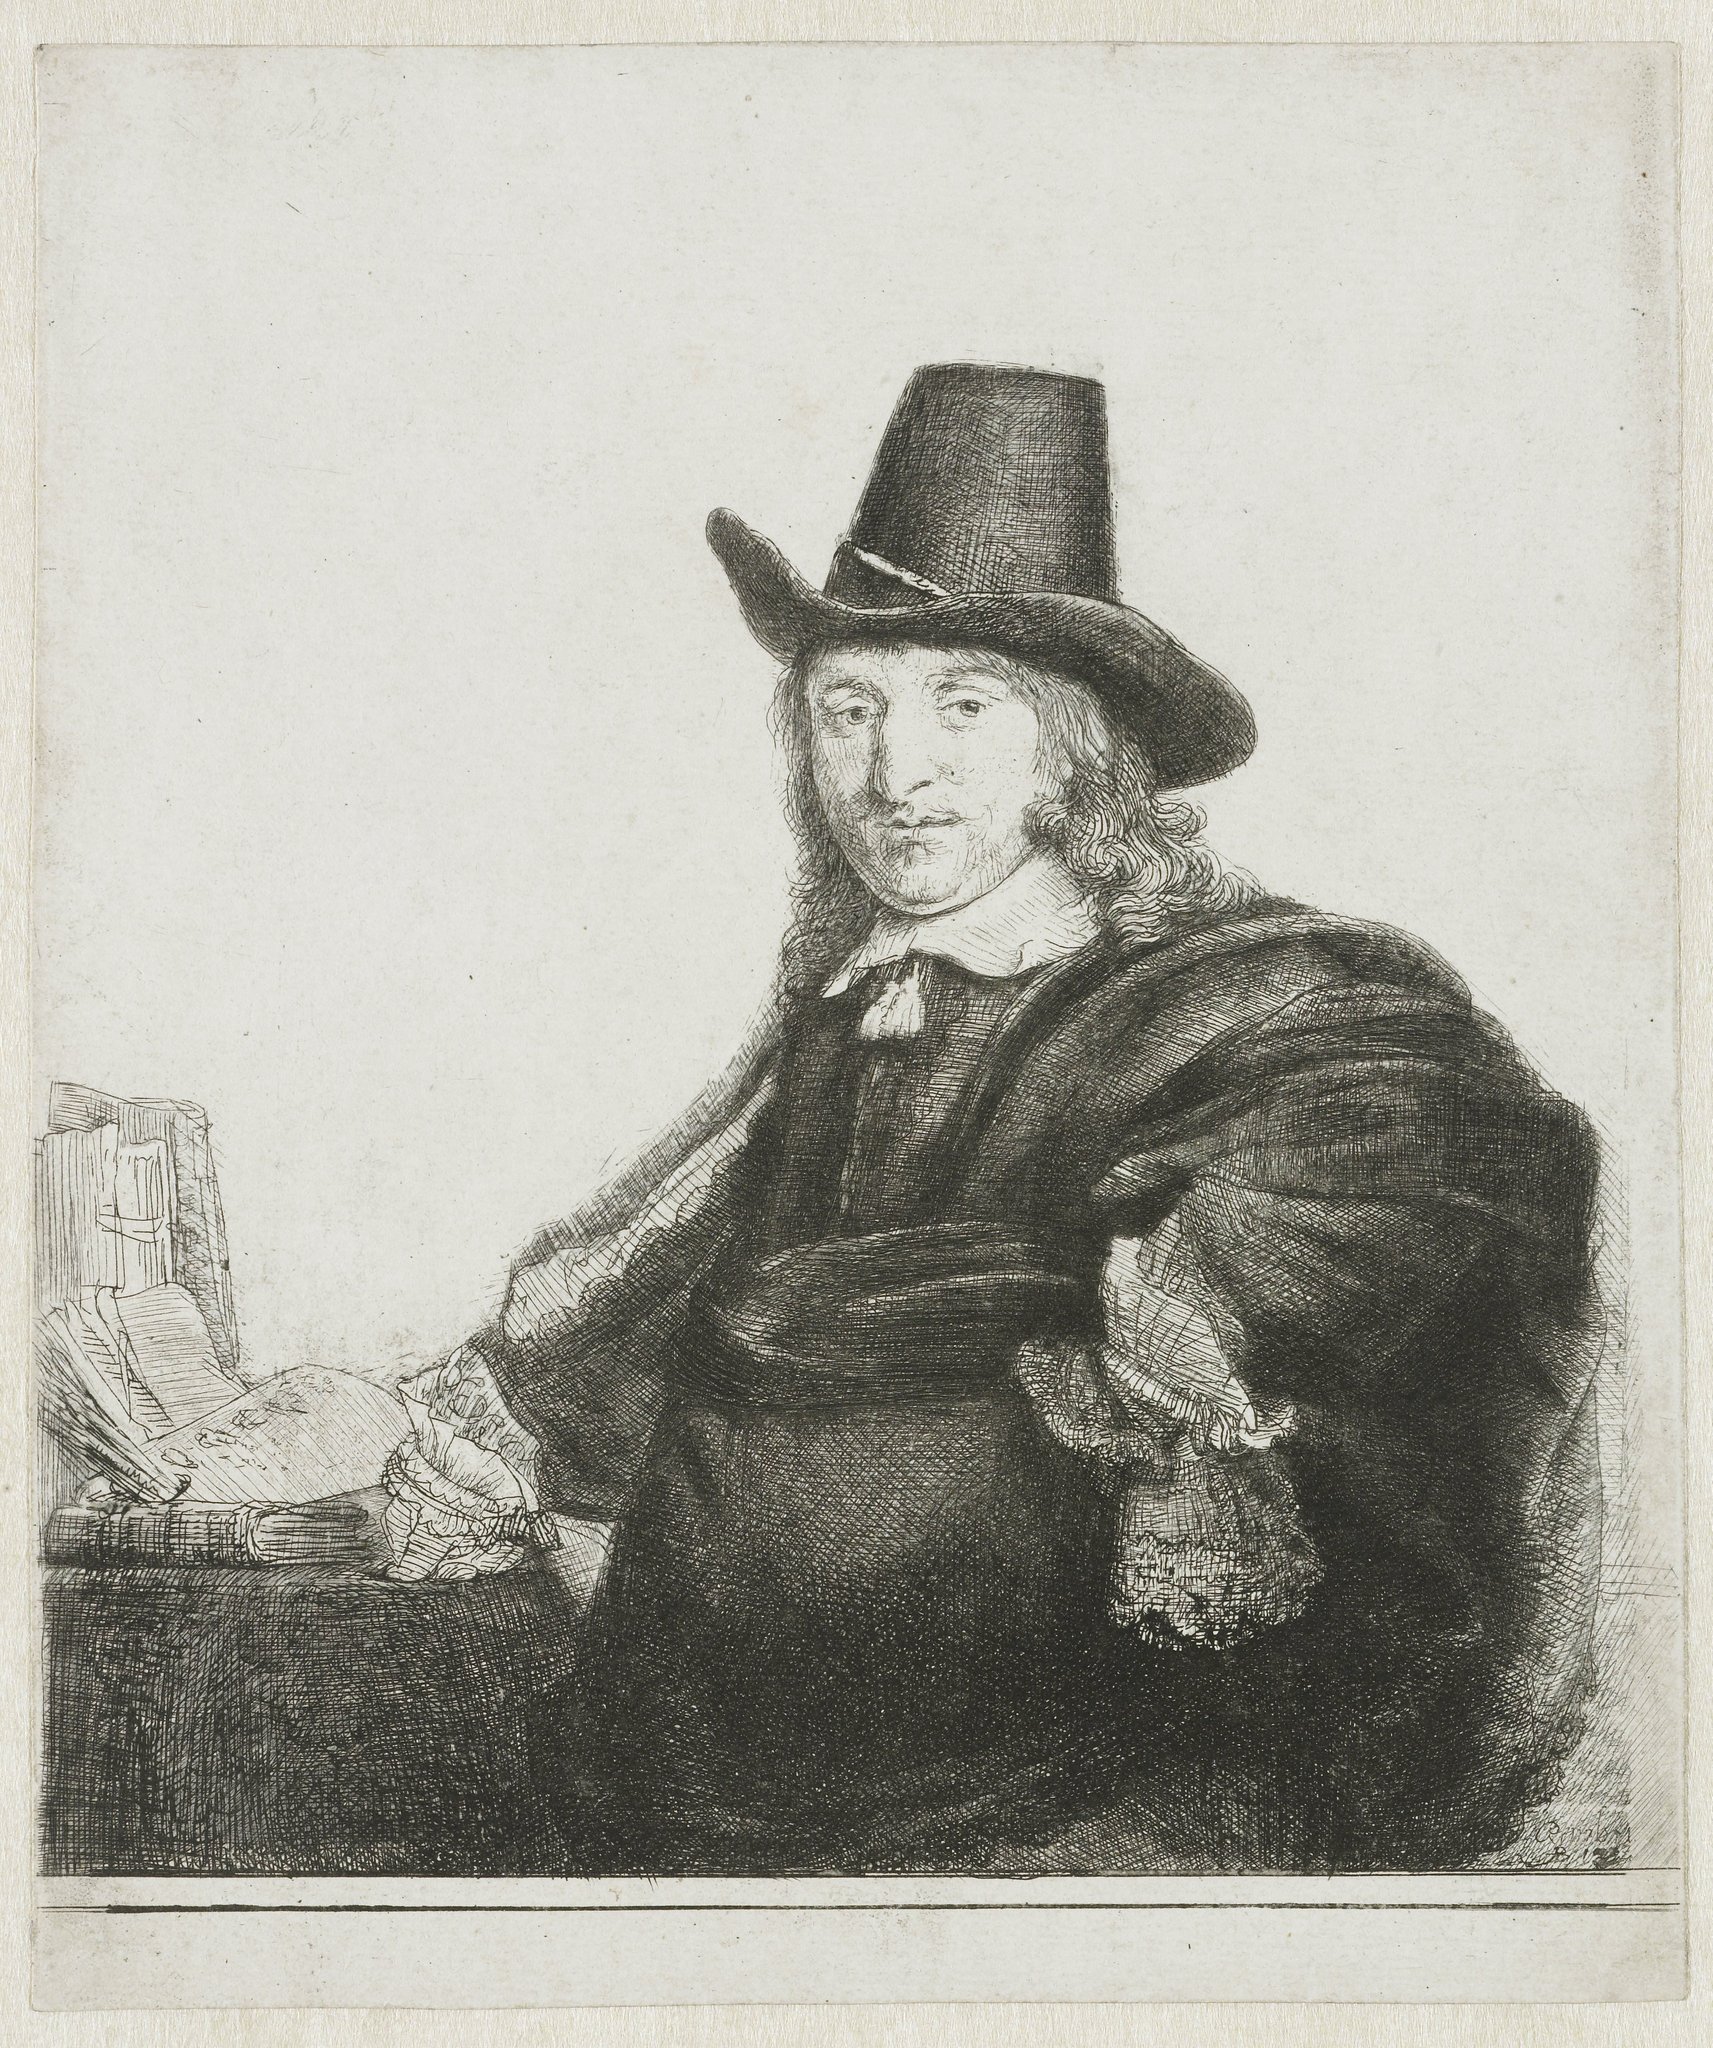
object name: print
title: Jan Asselijn, painter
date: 1647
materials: paper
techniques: drypoint, etching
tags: amsterdam, draughtsman, jan asselijn, portrait, self-portrait of painter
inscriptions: signature and date: ‘Rembr / f 16’, collector's mark: Lugt 2228 a